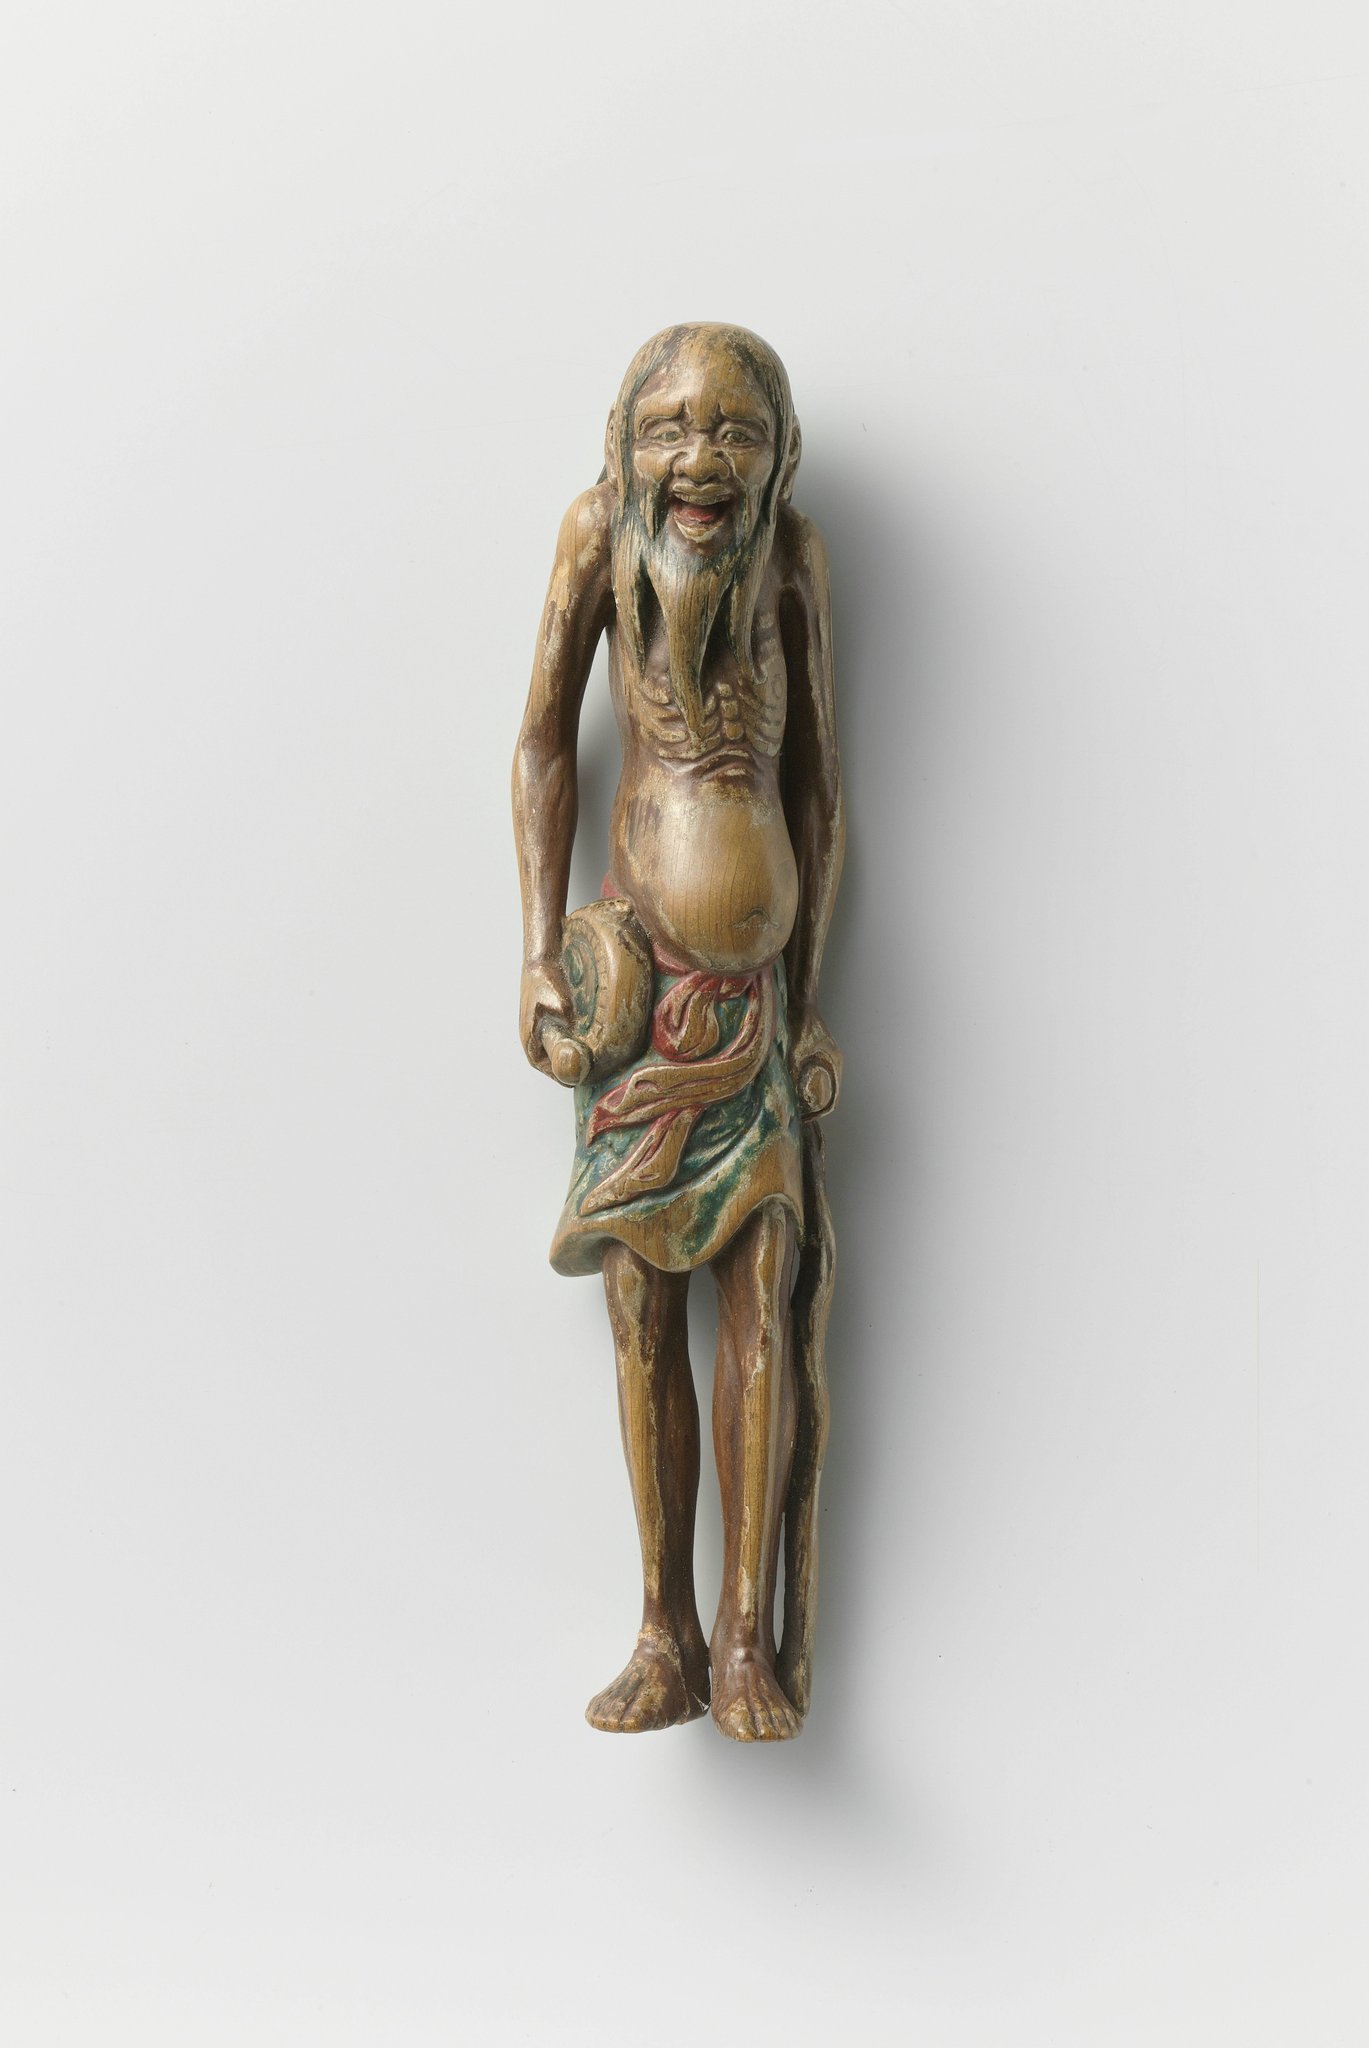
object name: netsuke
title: Netsuke in the form of a holy man with a drum and staff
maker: Anonymous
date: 1700-1900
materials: wood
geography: japan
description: Taoistische heilige (sennin) met trommel en staf. Gepolychromeerd hout.